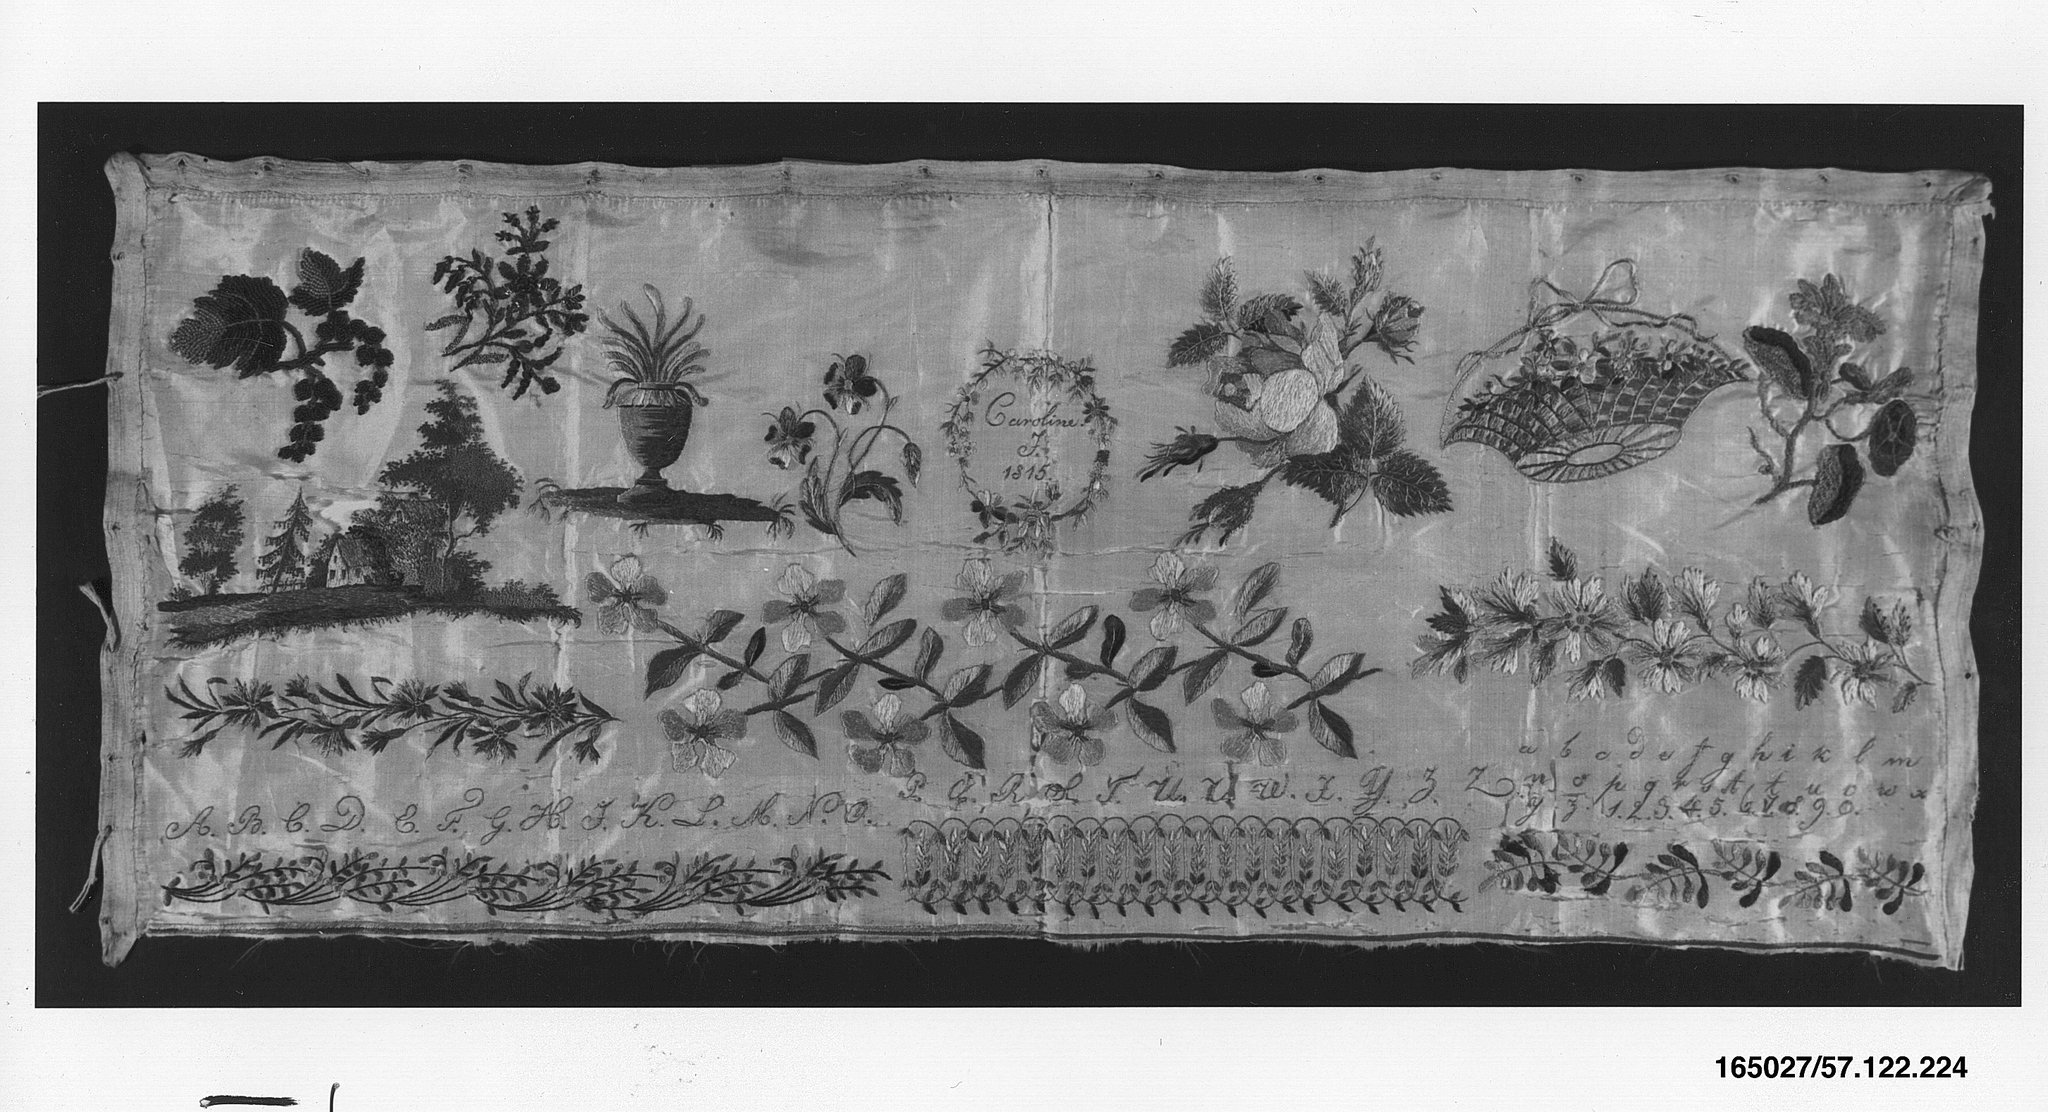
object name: sampler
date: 1815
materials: silk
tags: flowers